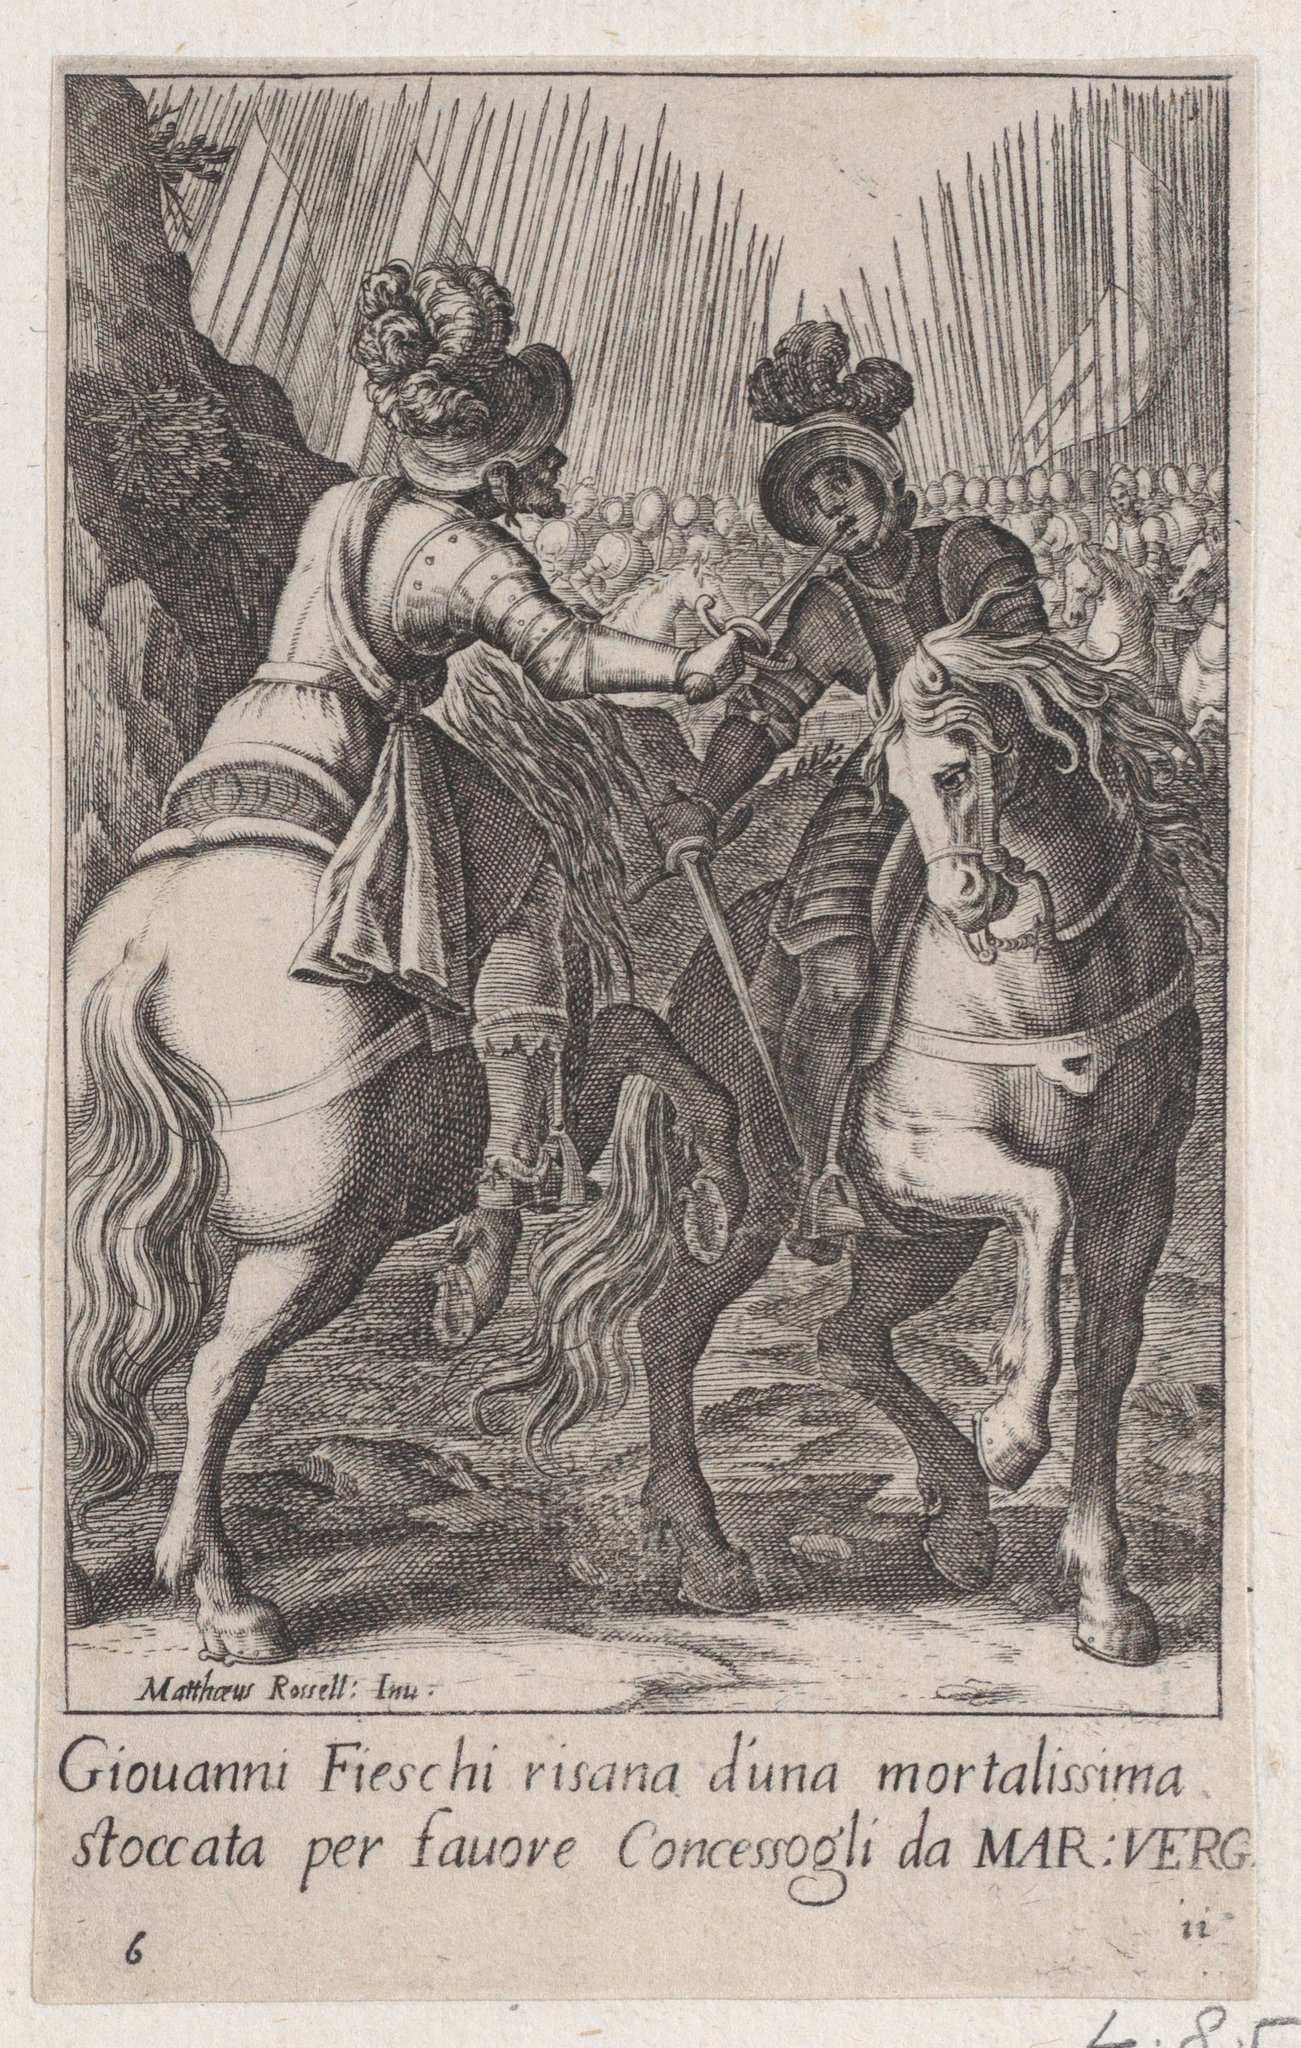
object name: print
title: Giovanni Fieschi, from Scelta d'Alcuni Miracoli e Grazie della Santissima Nunziata di Firenze (Selection of Some Miracles and Graces that Occurred in the Church of the Annunziata in Florence)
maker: jacques callot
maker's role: artist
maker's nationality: french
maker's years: 1592-1635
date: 1611-1619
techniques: engraving